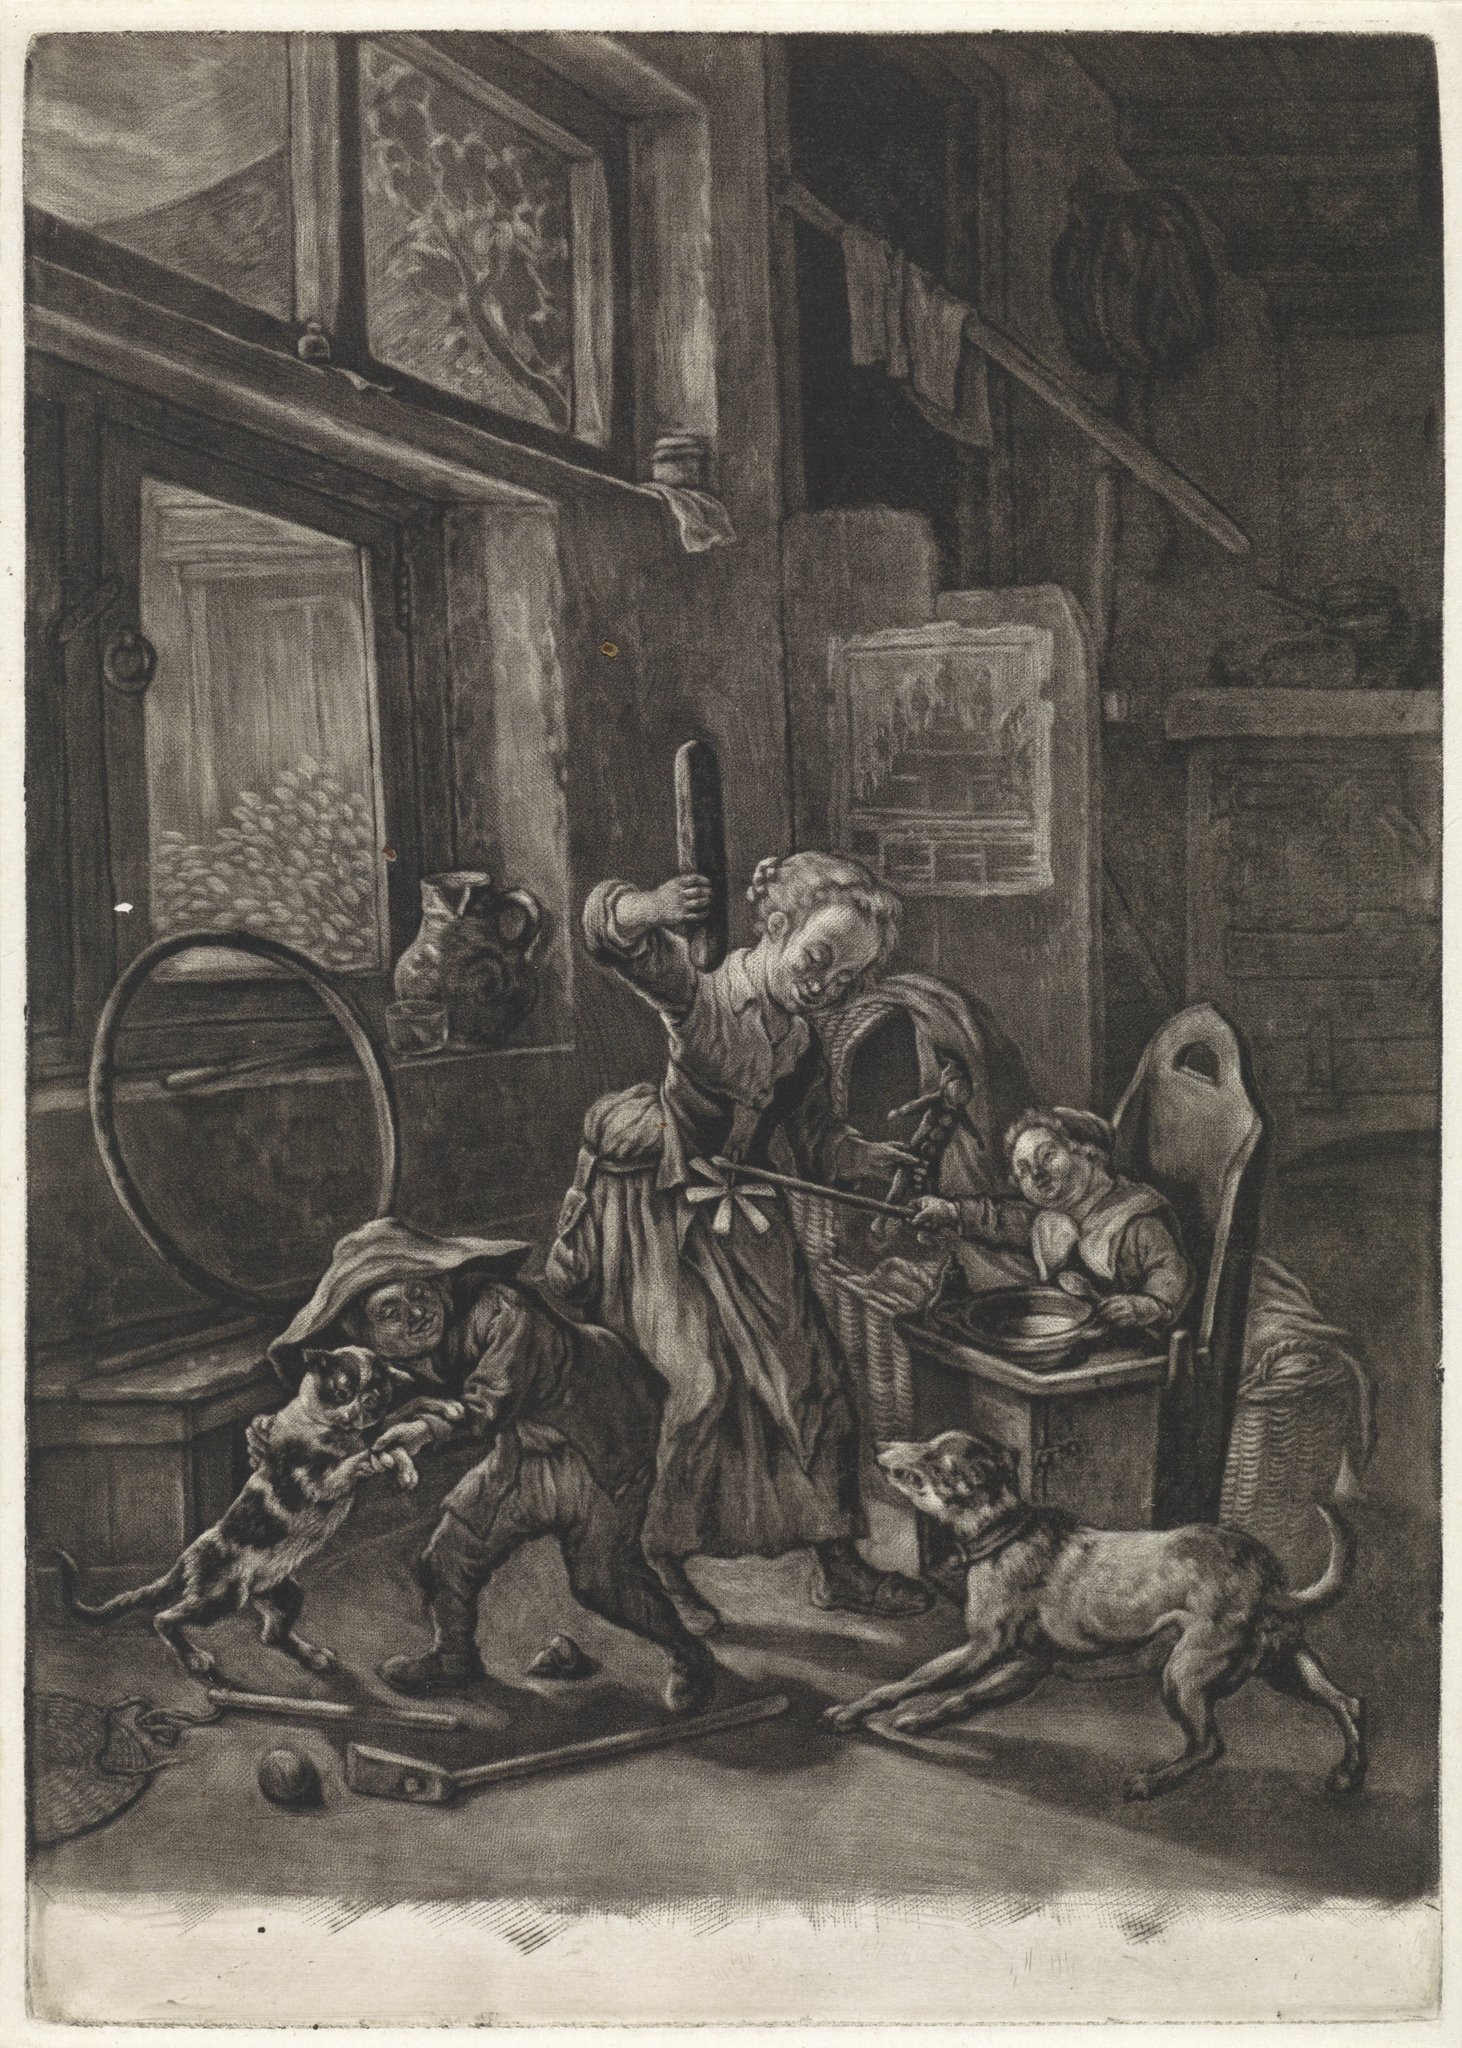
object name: print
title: De kindertijd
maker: cornelis dusart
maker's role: draughtsman, painter, print maker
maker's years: 1660-1704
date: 1680-1704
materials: paper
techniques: mezzotint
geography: haarlem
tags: children's games and plays, cat, the ages of man, dog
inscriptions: collector's mark: Lugt 240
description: Interieur met spelende kinderen van verschillende leeftijden. Een jong kind zit in een kinderstoel en speelt met een molen terwijl een meisje zich met een pop en een stuk koek bezighoudt. Een jongen vermaakt zich met een kat en een hond. Aan de muur hangt een prent met daarop de 'De trap der leeftijden'. De prent is onderdeel van een reeks van vier prenten over de leeftijden van de mens.